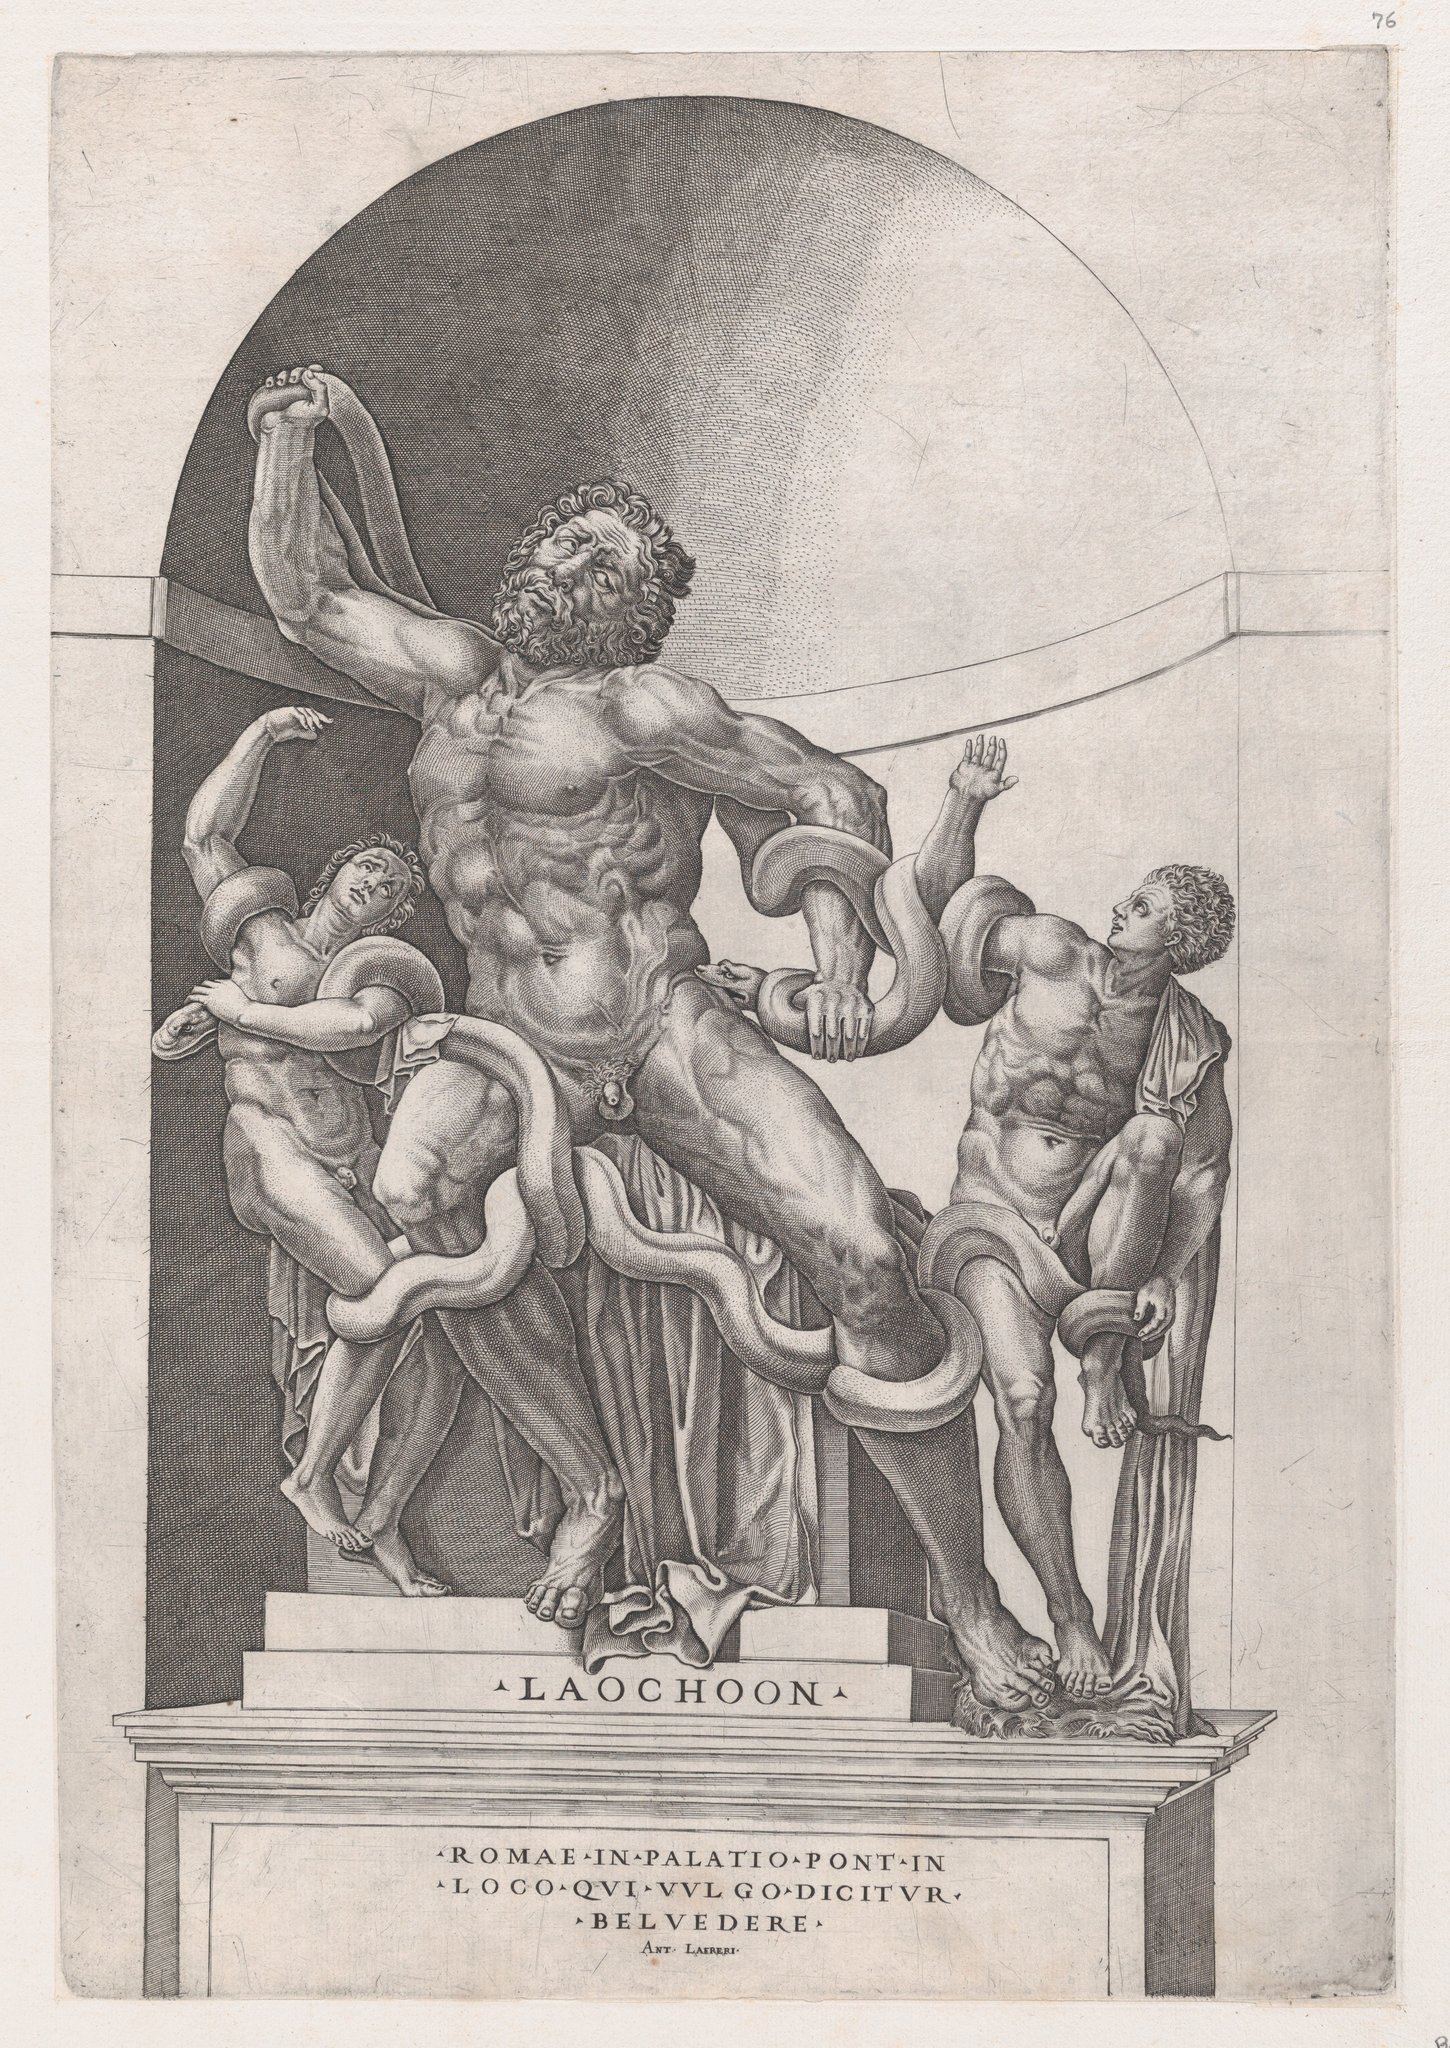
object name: print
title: Laocoon, from "Speculum Romanae Magnificentiae"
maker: nicolas beatrizet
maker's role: artist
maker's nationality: french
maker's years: 1515-1566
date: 1501-1600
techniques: engraving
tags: male nudes,serpents